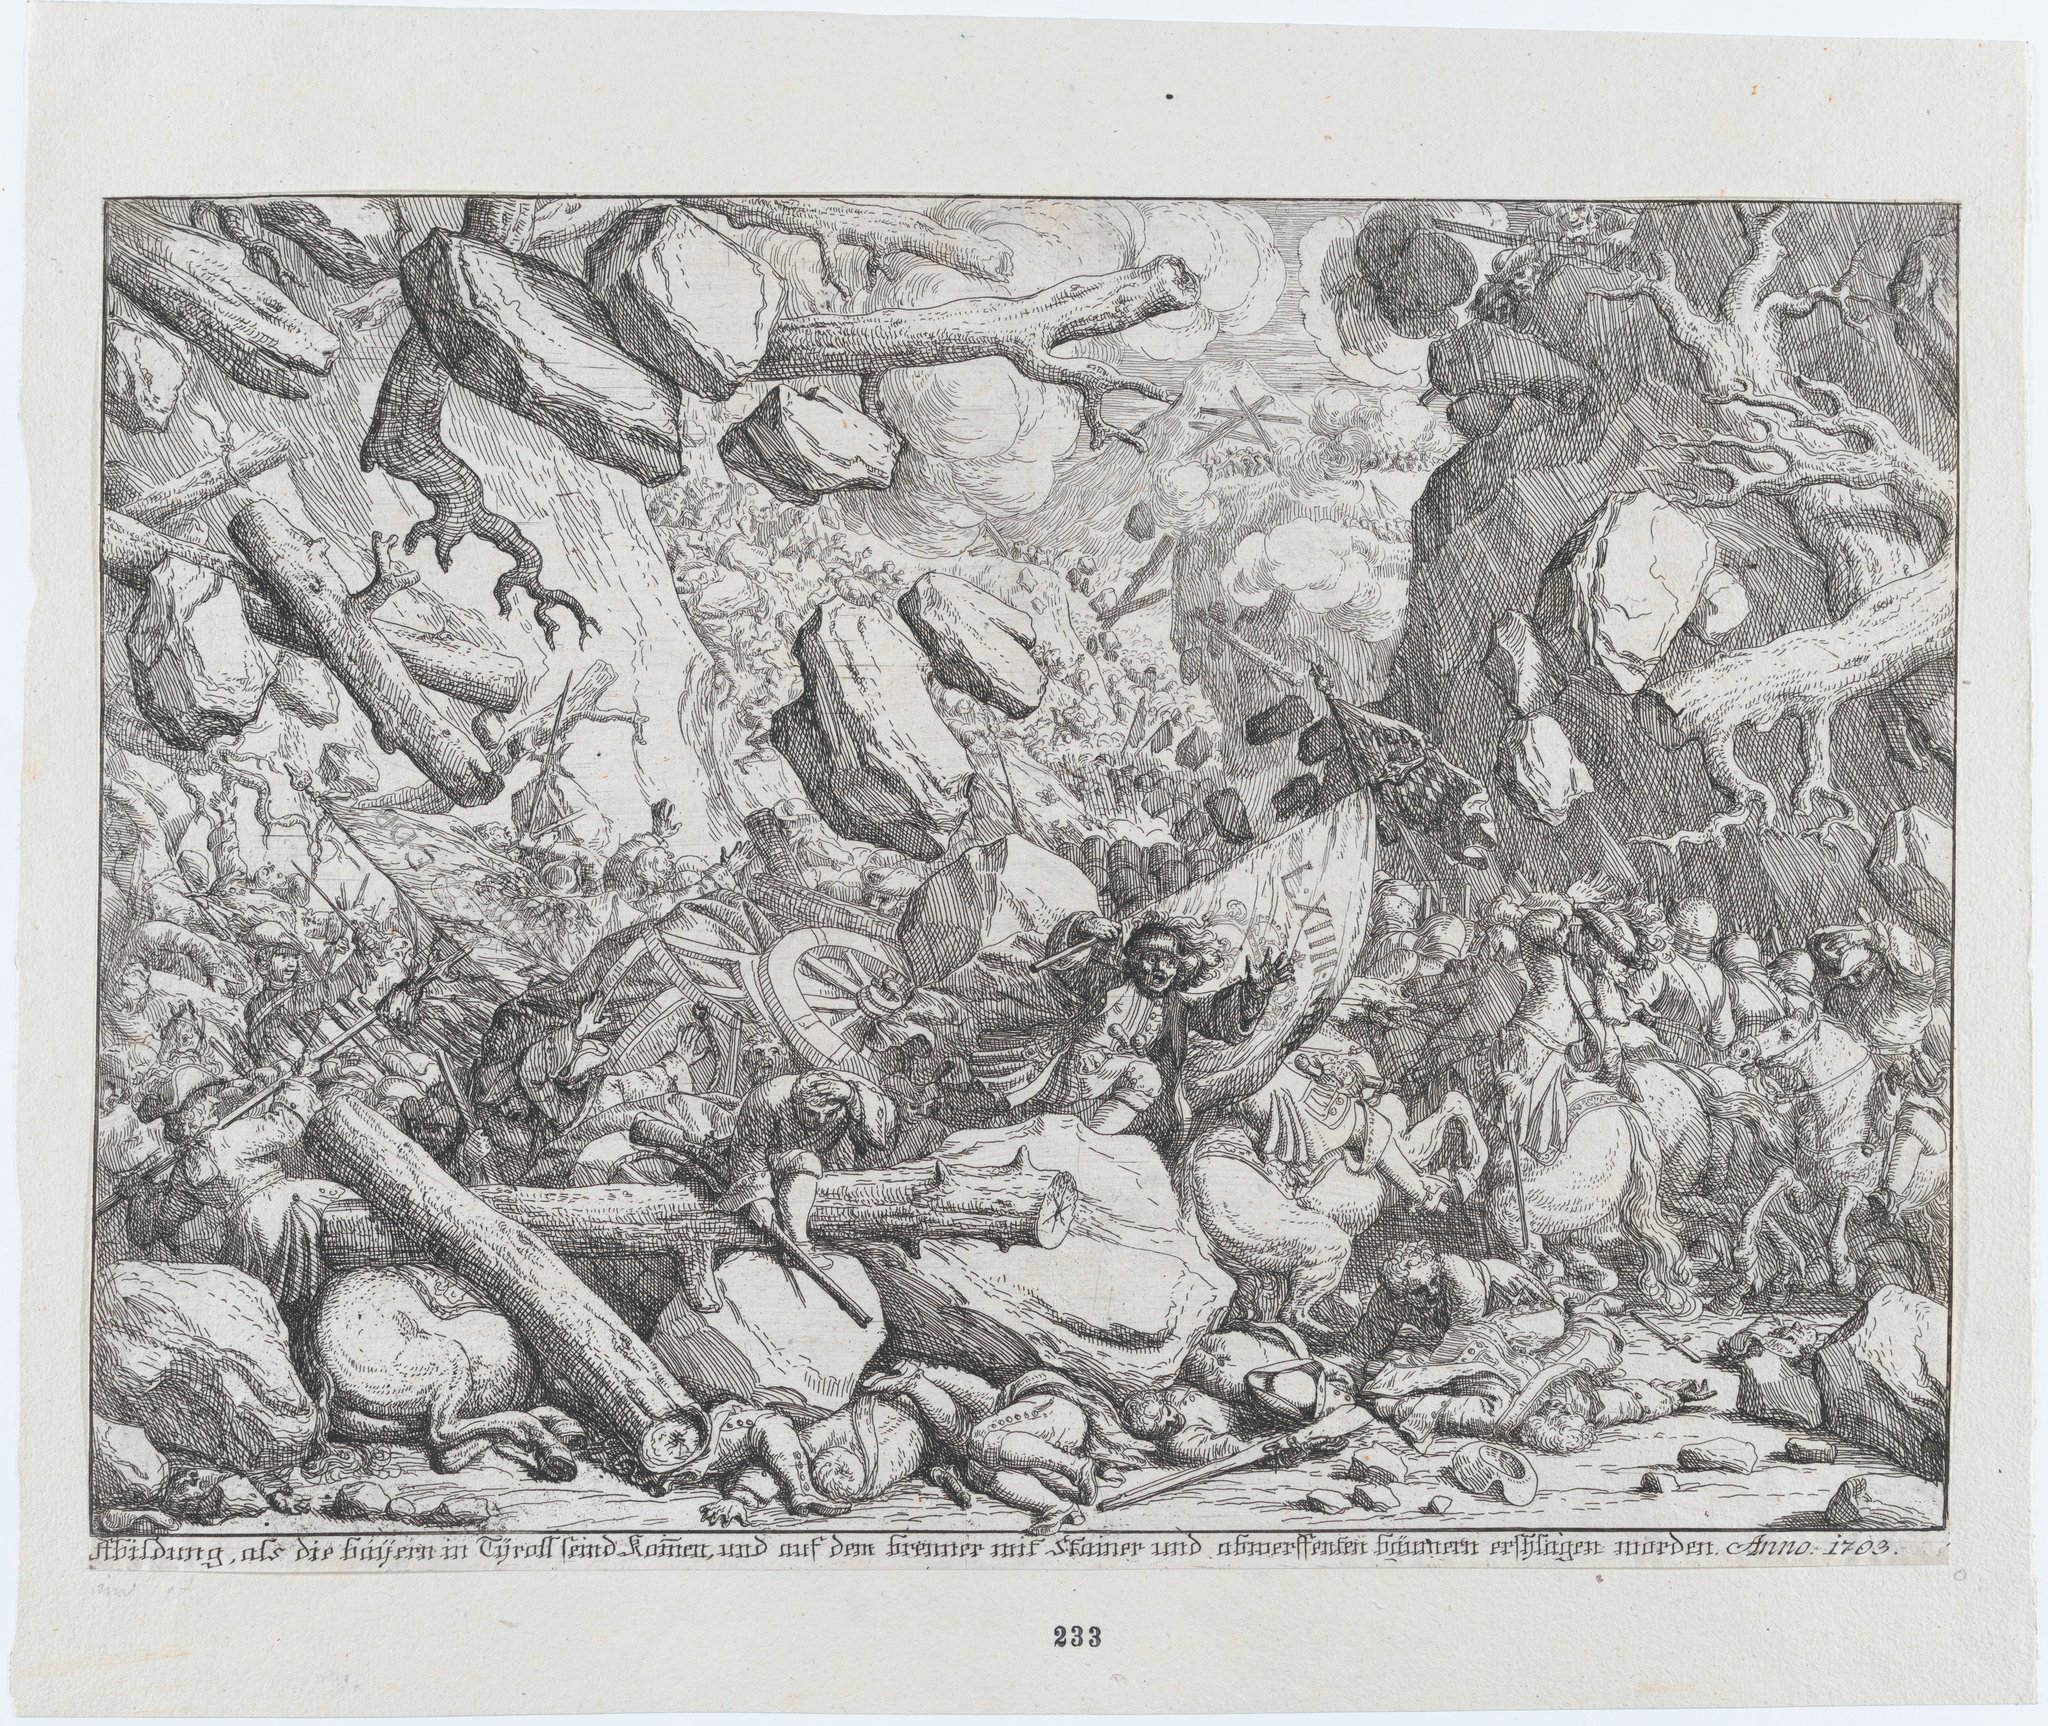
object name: print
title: Maximilian Emanuel and the Bavarian Army in a Narrow Pass in theTyrol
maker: franz joachim beich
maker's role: artist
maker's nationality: german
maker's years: 1665-1745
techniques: etching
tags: army,horses